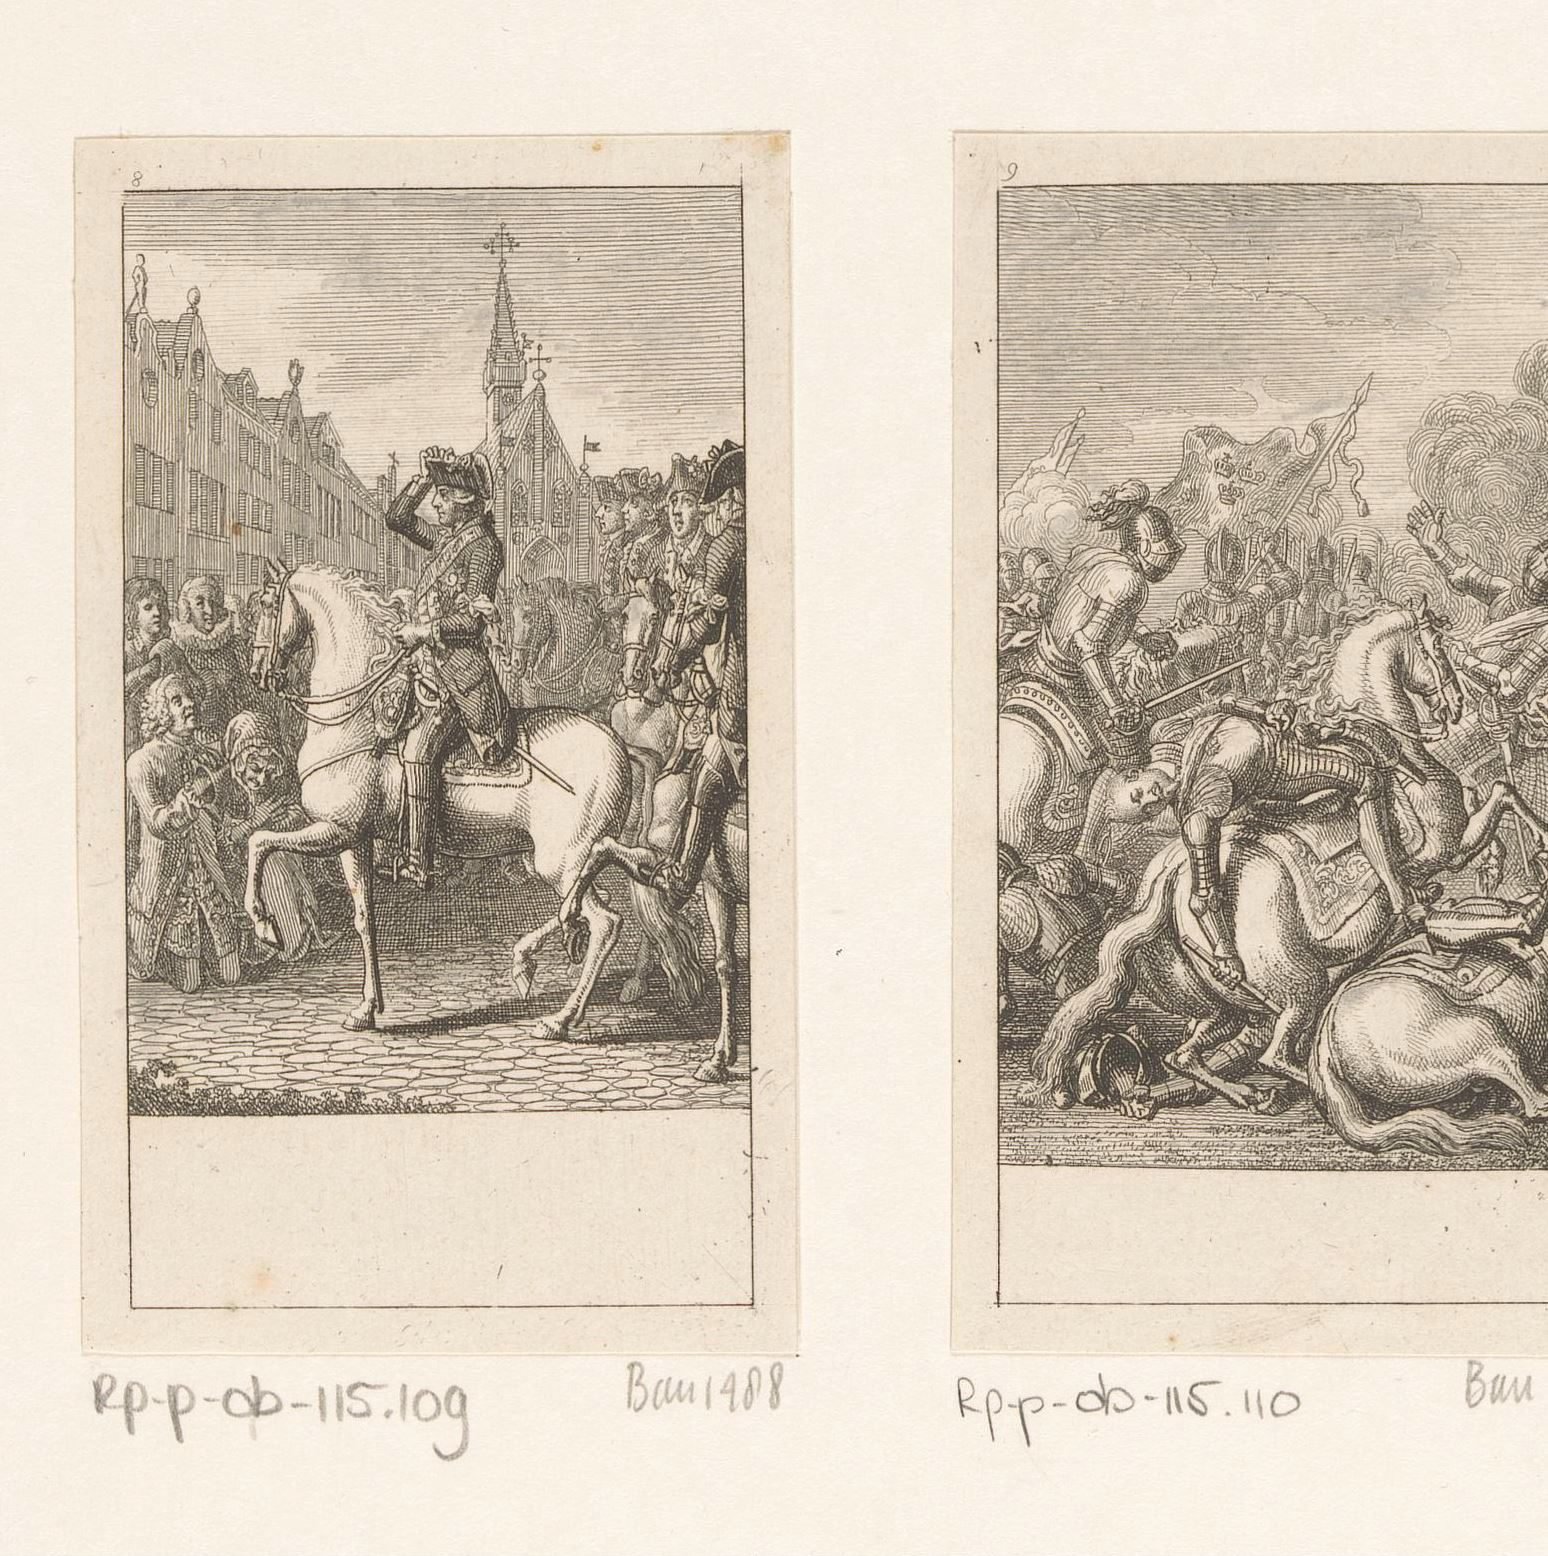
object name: print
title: Gustaaf III van Zweden op zijn paard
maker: daniel nikolaus chodowiecki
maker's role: draughtsman, print maker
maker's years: 1726-1801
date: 1790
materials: paper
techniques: etching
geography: berlin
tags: riding a horse, ass, or mule; rider, horseman, history, ruler, sovereign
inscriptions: collector's mark: Lugt 2228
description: Latere staat gebruikt voor: Gothaischer Hof Kalender zum Nutzen und Vergnügen eingerichtet auf das Jahr 1791. Gotha: C. W. Ettinger, [1790].